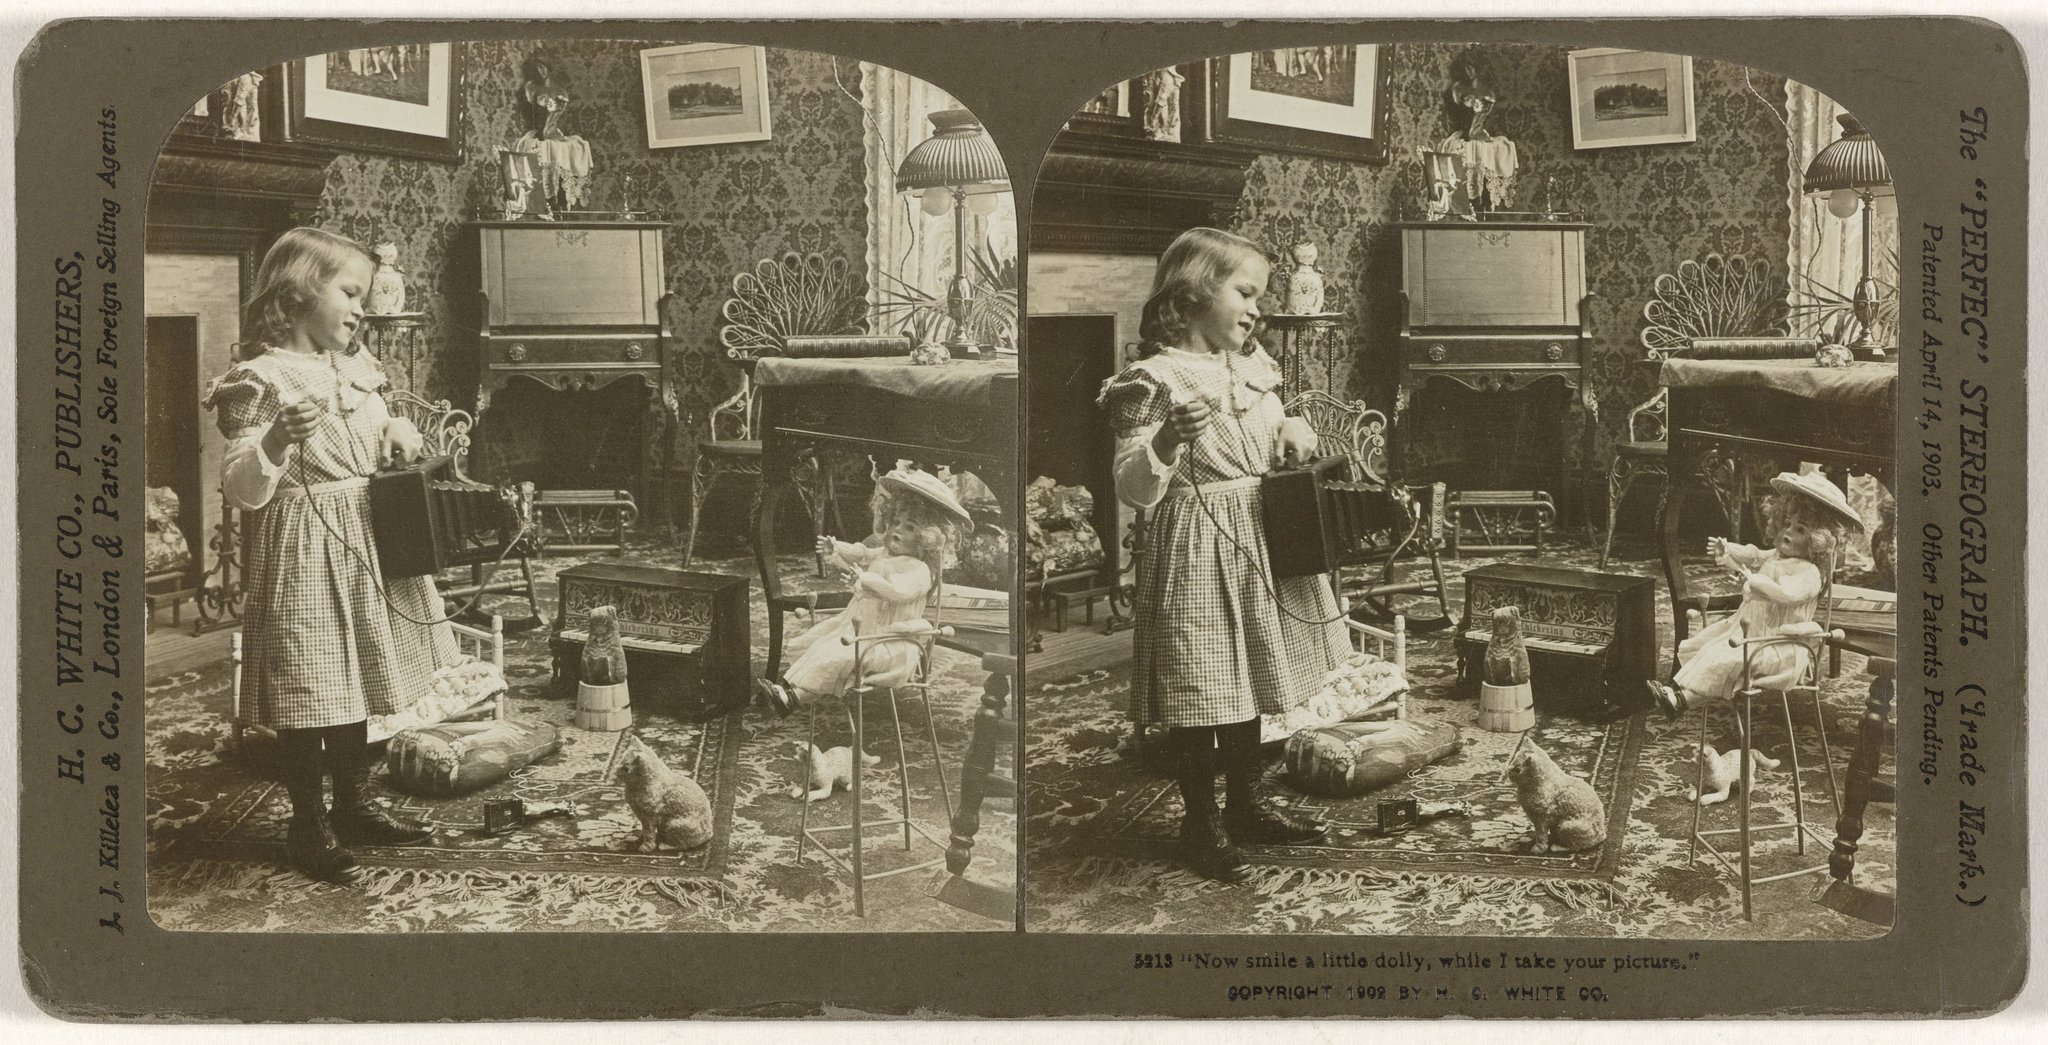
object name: stereograph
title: Meisje maakt een foto van haar pop in een huiskamer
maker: Anonymous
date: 1902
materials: cardboard, photographic support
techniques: gelatin silver print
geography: london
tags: taking photographs, girl (child between toddler and youth), (playing with) dolls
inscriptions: inscription: ‘The " PERFEC" STEREOGRAPH. (Trade Mark.)/ Patented April 14, 1903. Other Patents Pending.’, inscription, number: ‘5213’, copyright notice: ‘Copyright 1902 by H. C. White co.’